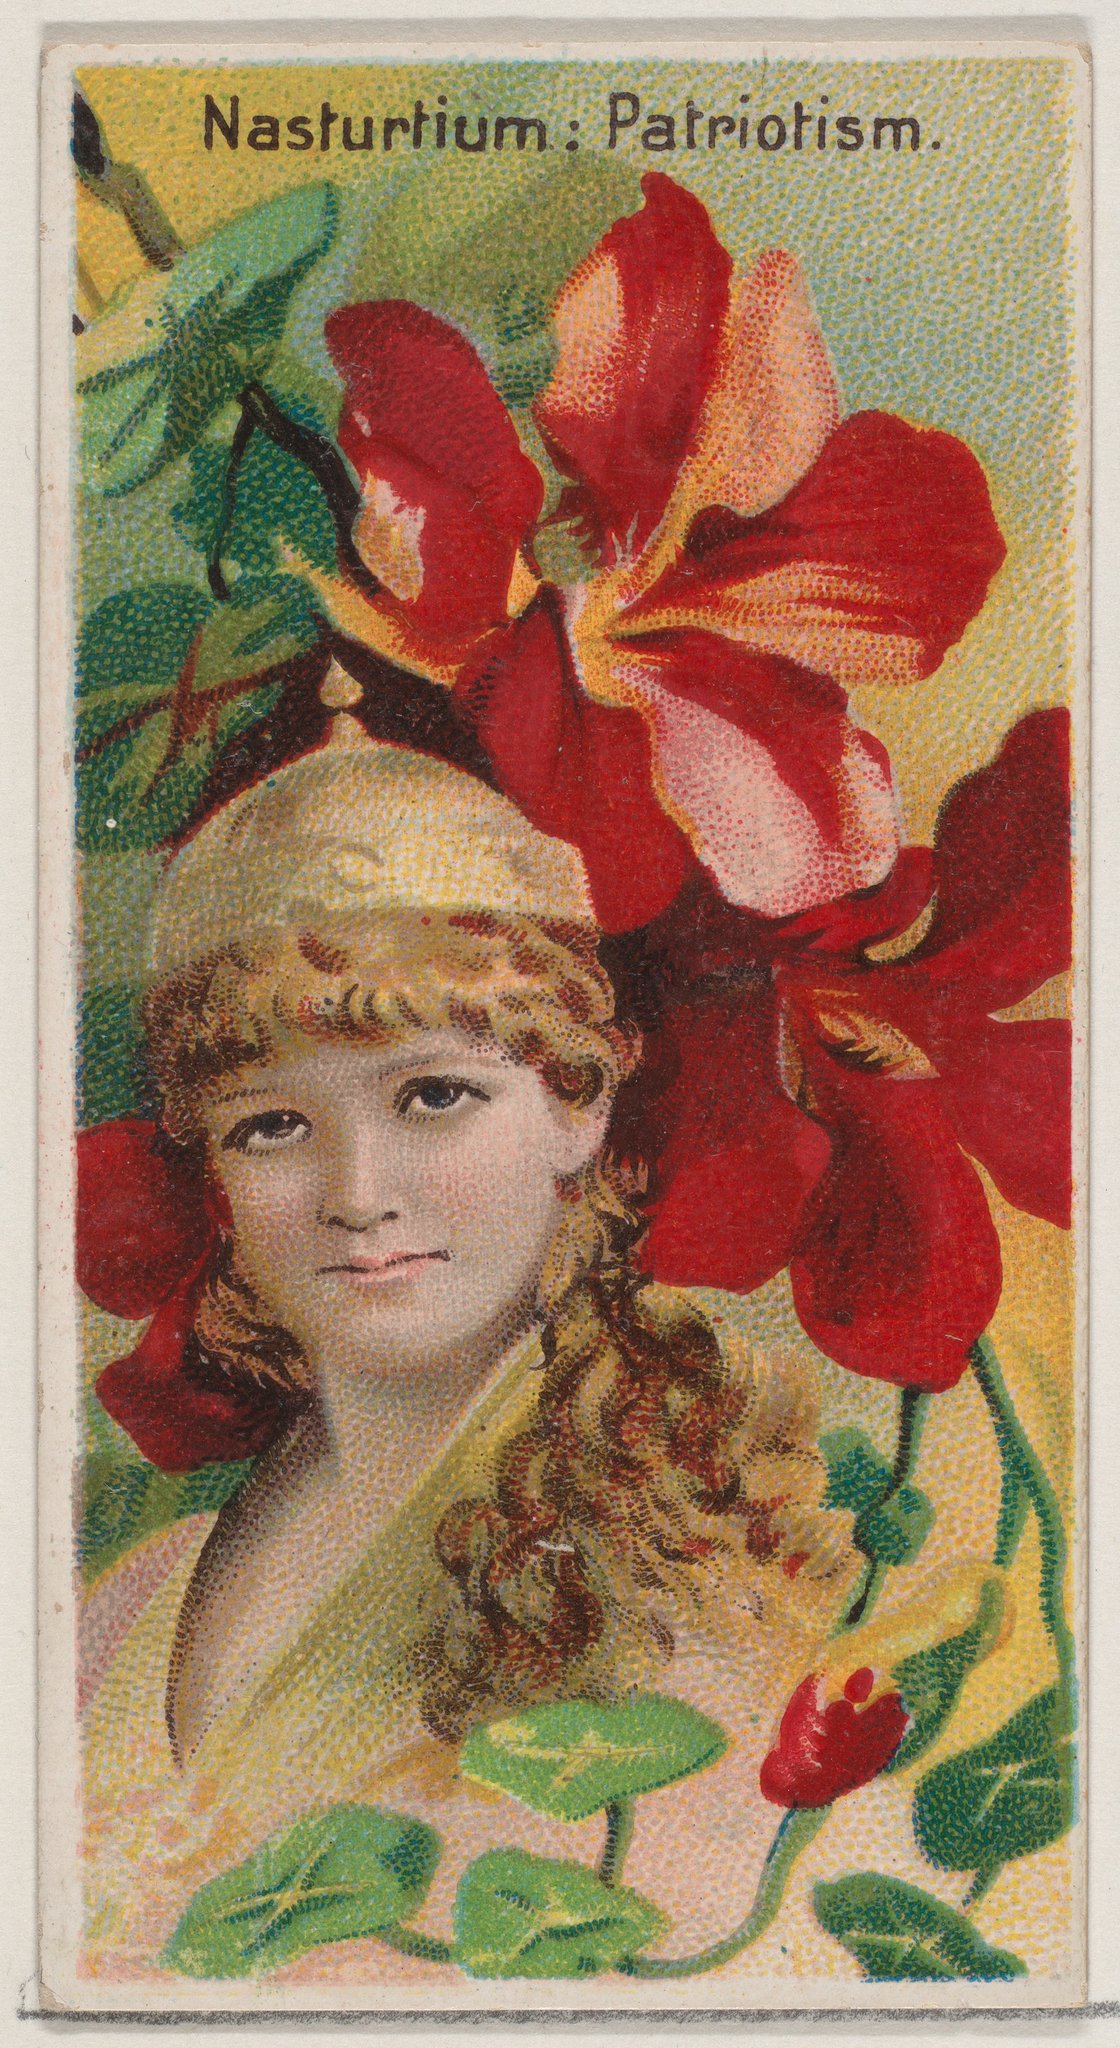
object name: print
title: Nasturtium: Patriotism, from the series Floral Beauties and Language of Flowers (N75) for Duke brand cigarettes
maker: american tobacco company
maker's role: publisher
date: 1892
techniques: color lithograph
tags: women,flowers